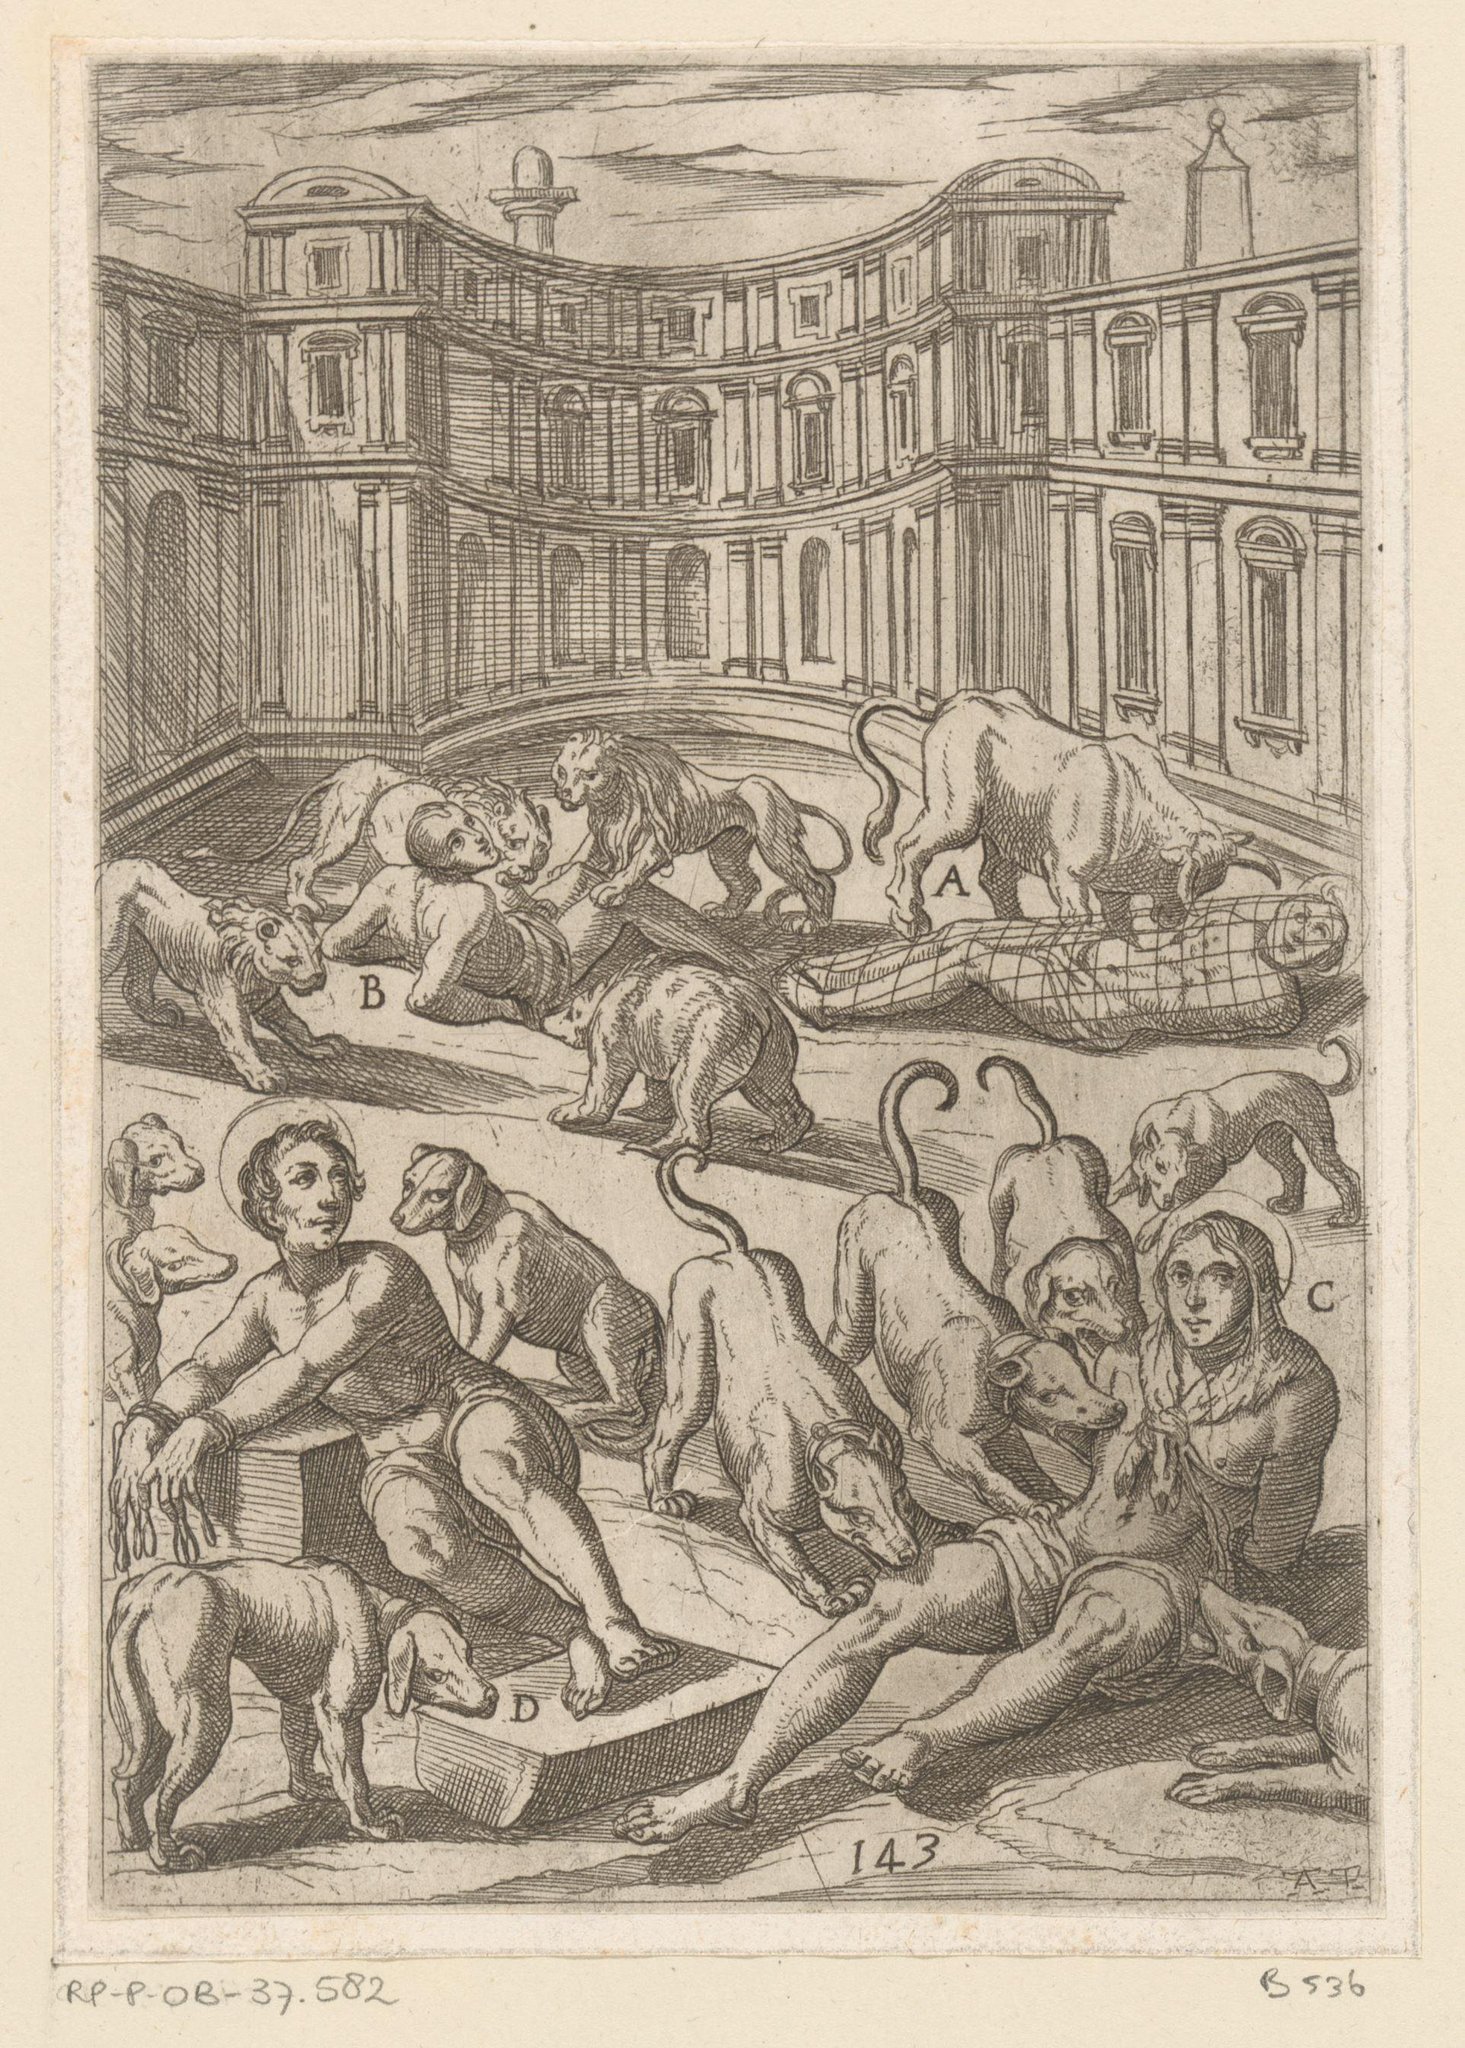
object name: print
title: Foltering: blootstelling aan honden en wilde dieren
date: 1565-1630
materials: paper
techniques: etching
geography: italy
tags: violent death ~ maltreatment, torture, torture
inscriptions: collector's mark: Lugt 240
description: Deze prent maakt deel uit van een reeks van 47 prenten (+ titelprent) met voorstellingen van martelmethoden. Deze prenten zijn in een andere editie gebruikt als illustraties voor Antonio Gallonio's 'Trattato degli Instrumenti di Martirio e delle Varie Maniere di Martoriare Usate dai Gentili contro Christiani' (Rome, Ascanio en Girolamo Dongangeli, 1591).